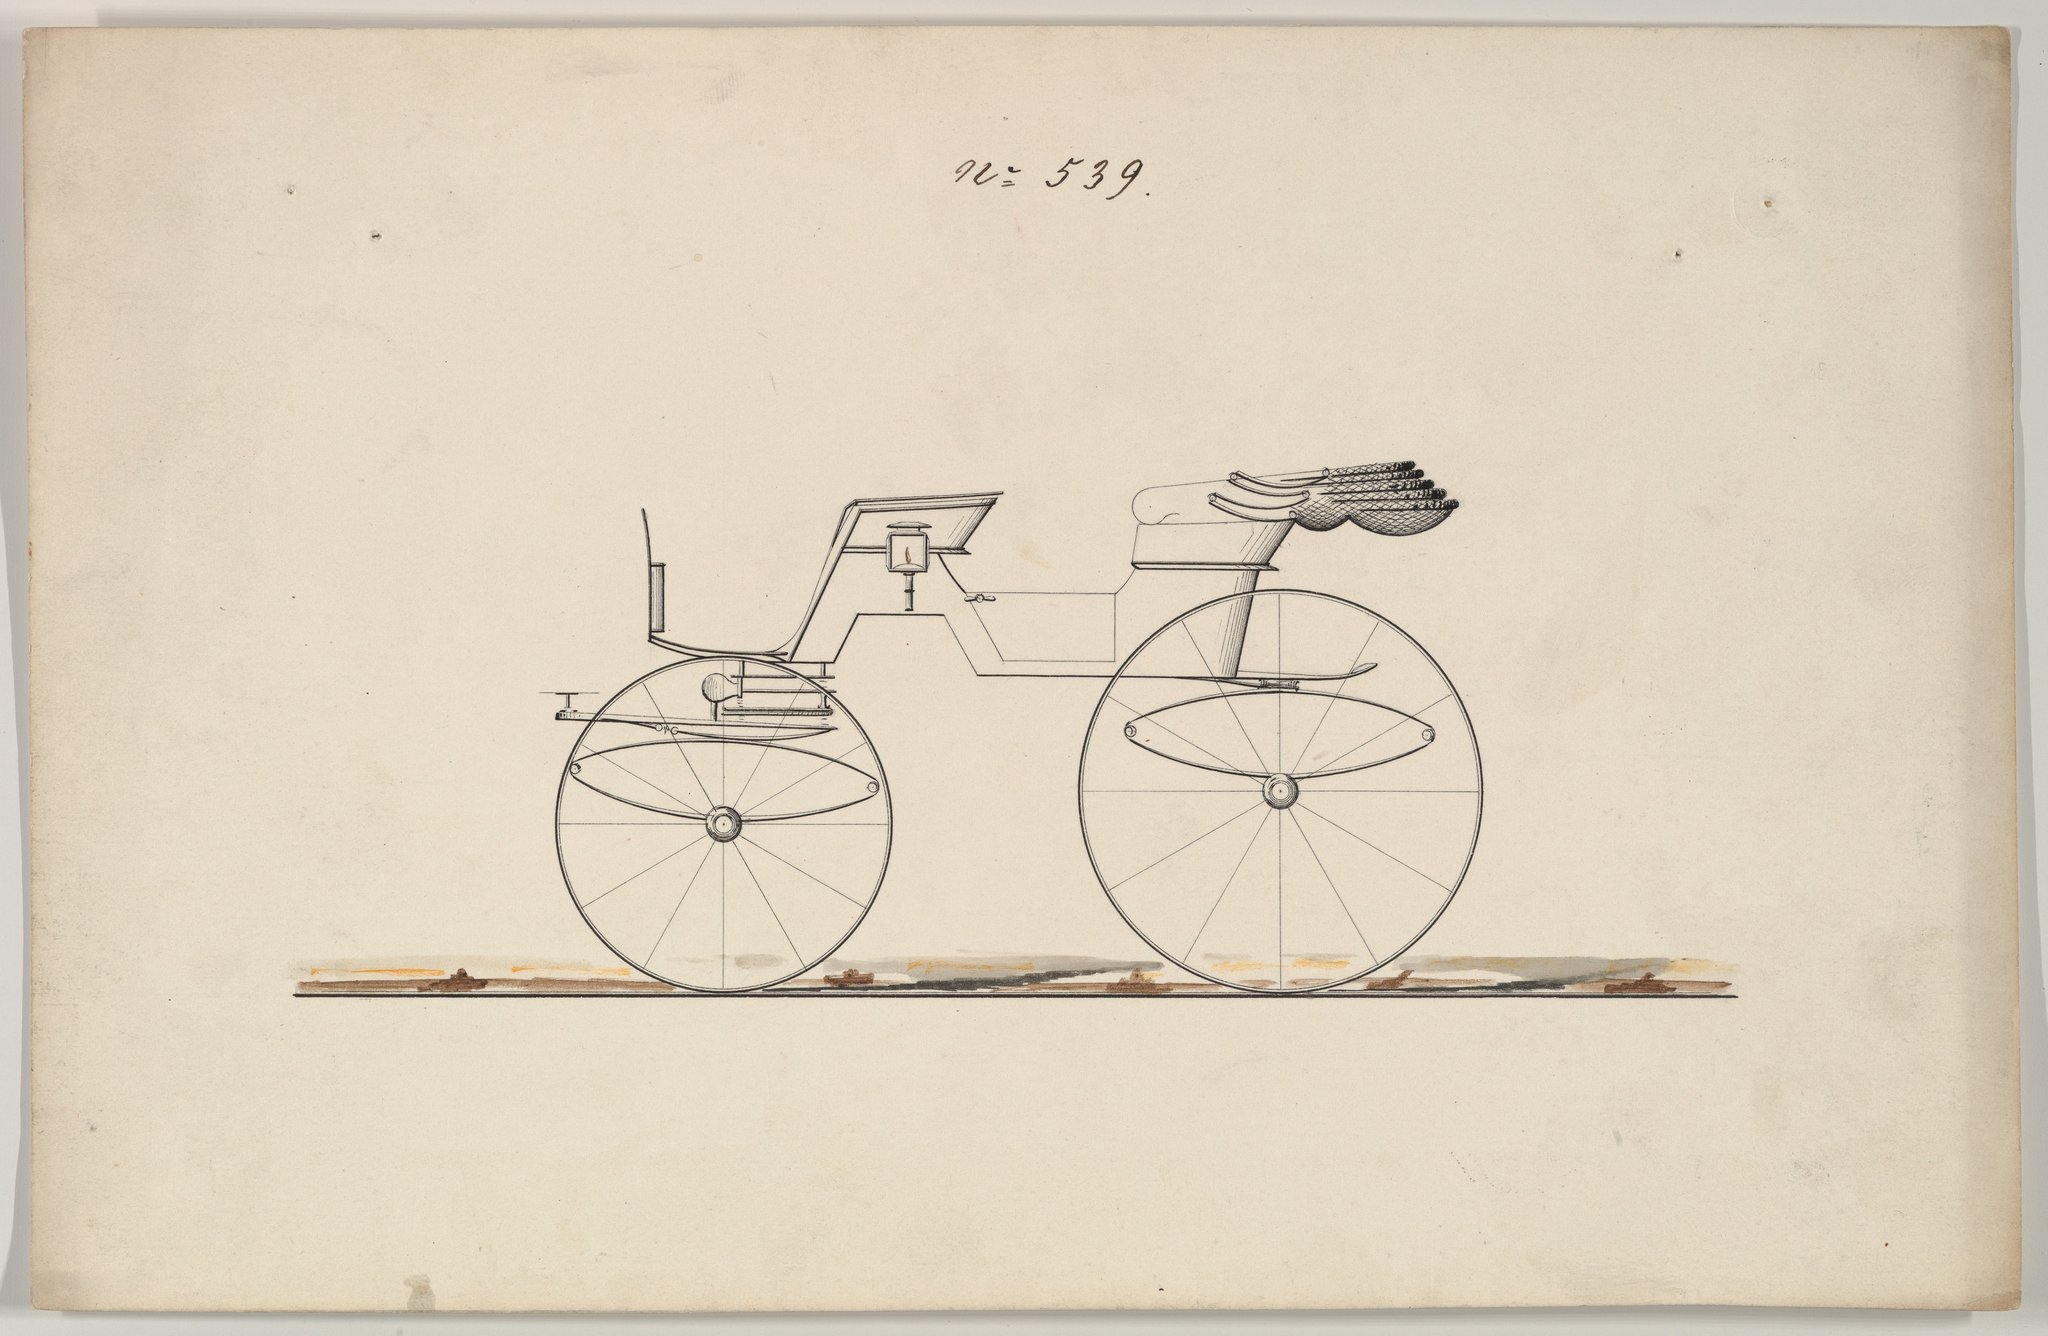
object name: drawing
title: Design for Phaeton, no. 539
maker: brewster & co.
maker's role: manufacturer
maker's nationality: american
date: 1850-1874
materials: gouache, ink, watercolor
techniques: pen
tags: carriages